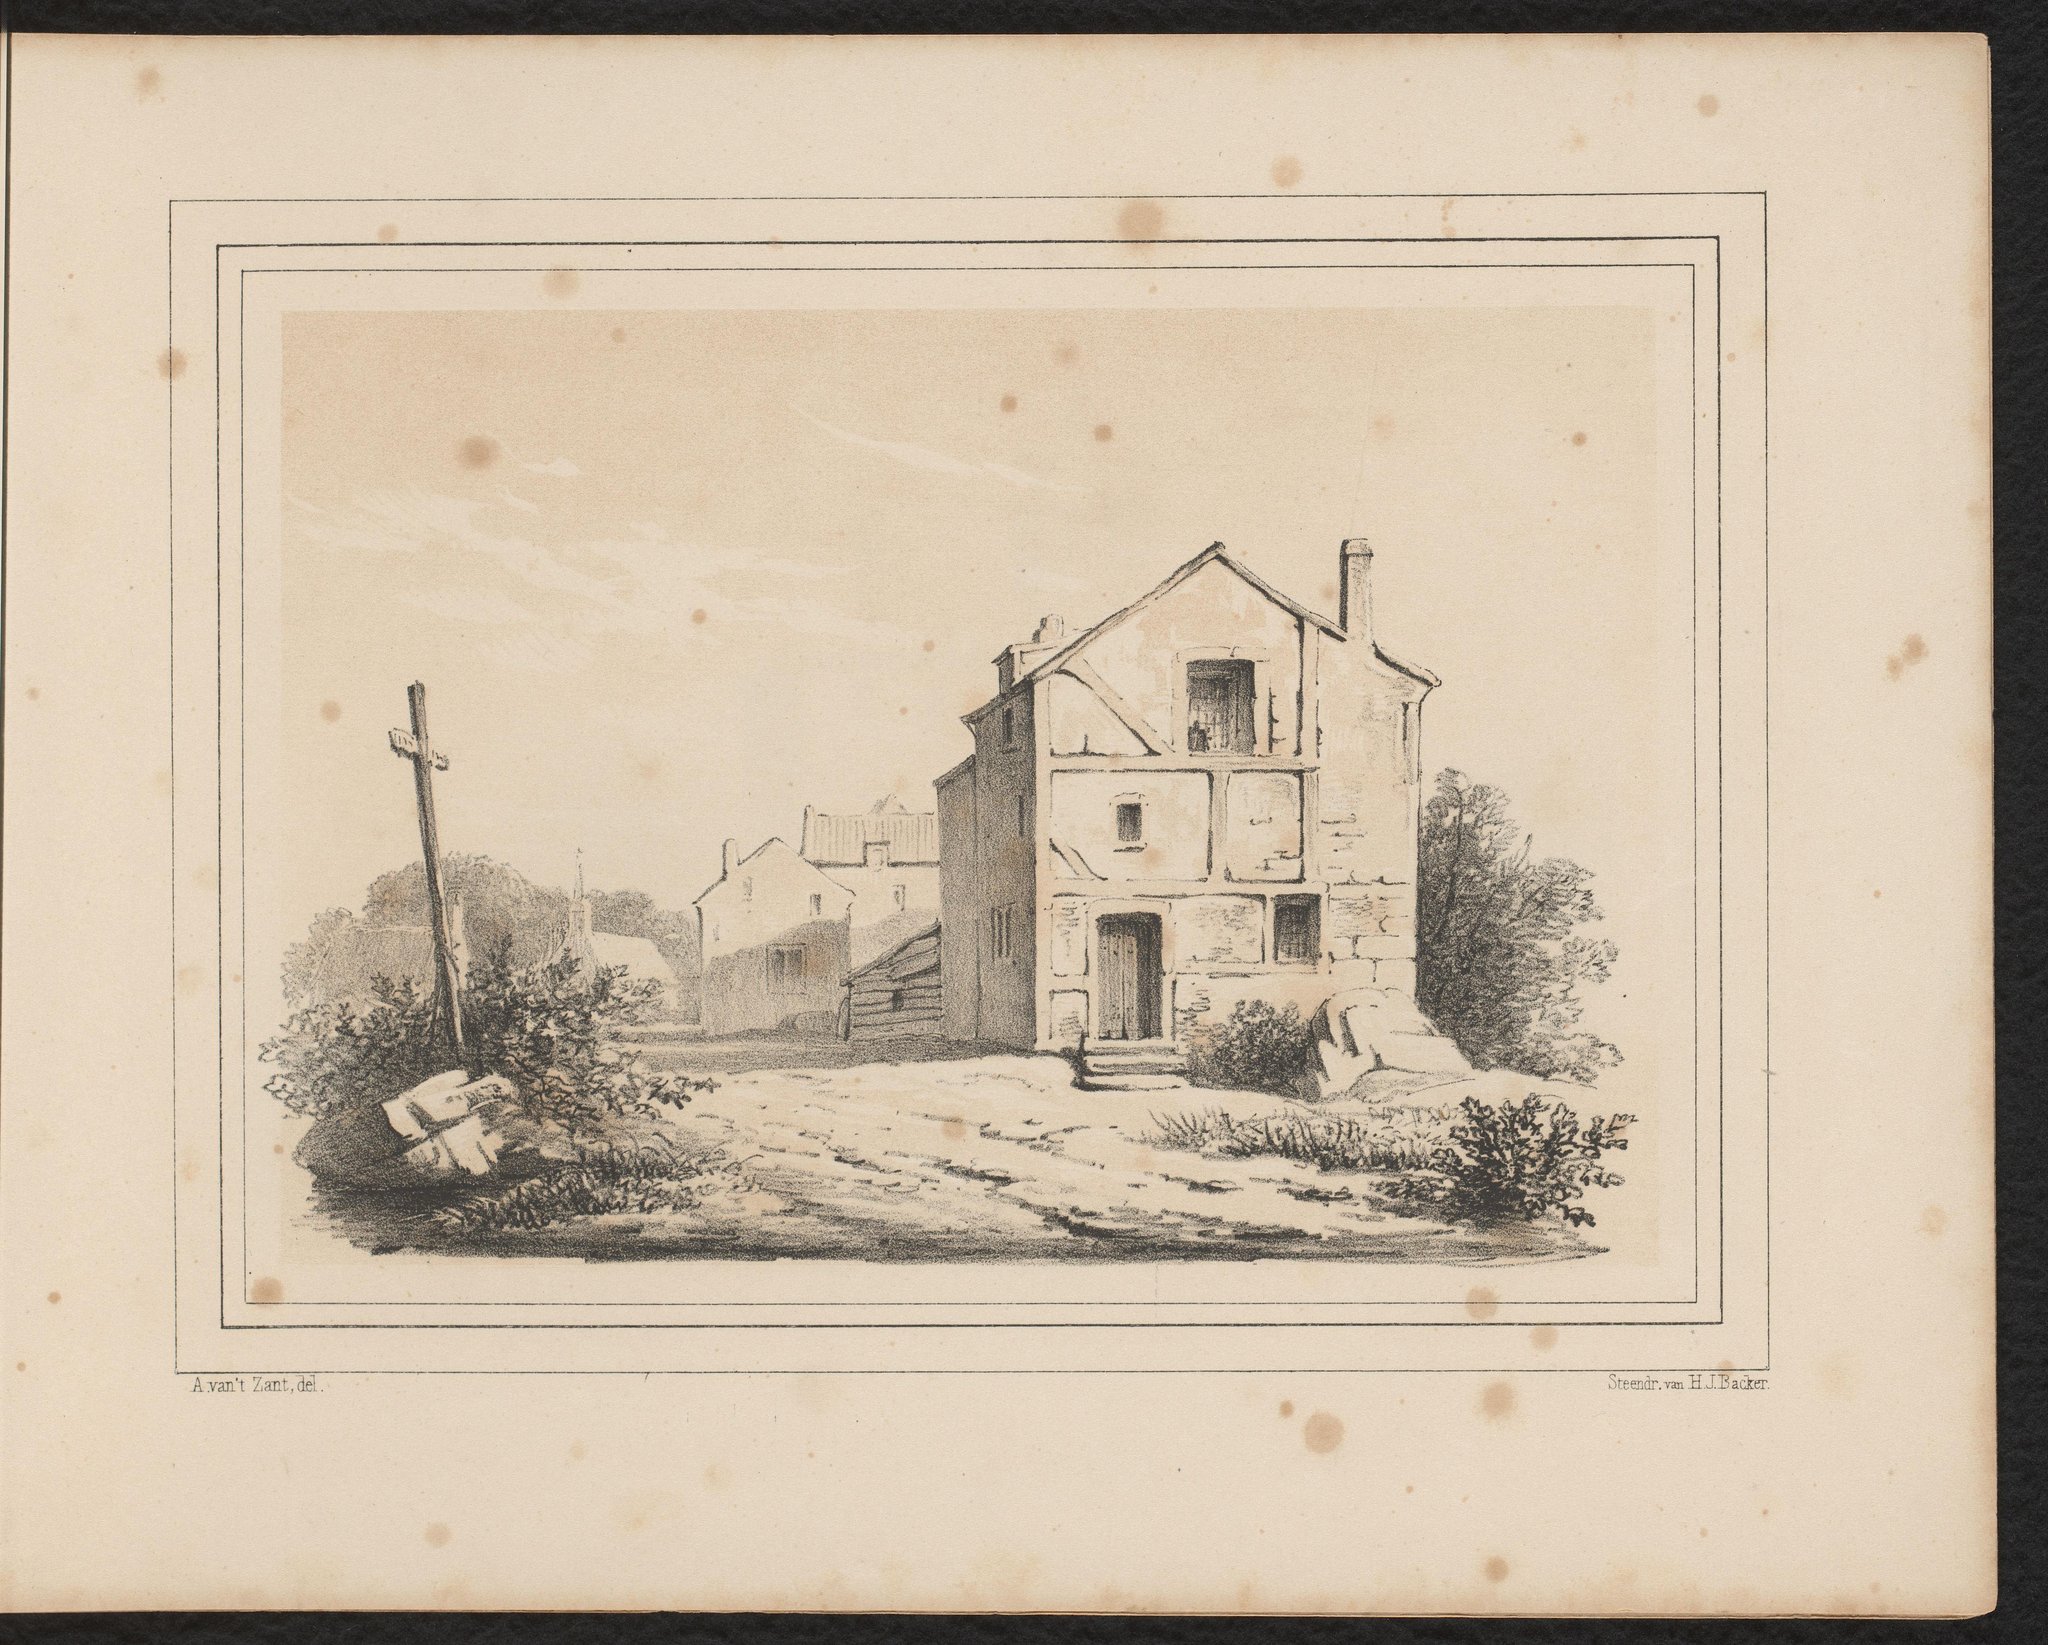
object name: album leaf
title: Zestal landschap studien door A. van 't Zant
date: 1822-1845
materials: paper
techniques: tone lithography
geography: dordrecht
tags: cross as symbol of christ, landscapes in the temperate zone, public road in village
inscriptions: collector's mark: Lugt 2233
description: Links van de weg staat een kruis, rechts enkele huizen. In de verte een kerk. Deze prent maakt deel uit van een omslag met zeven prenten.